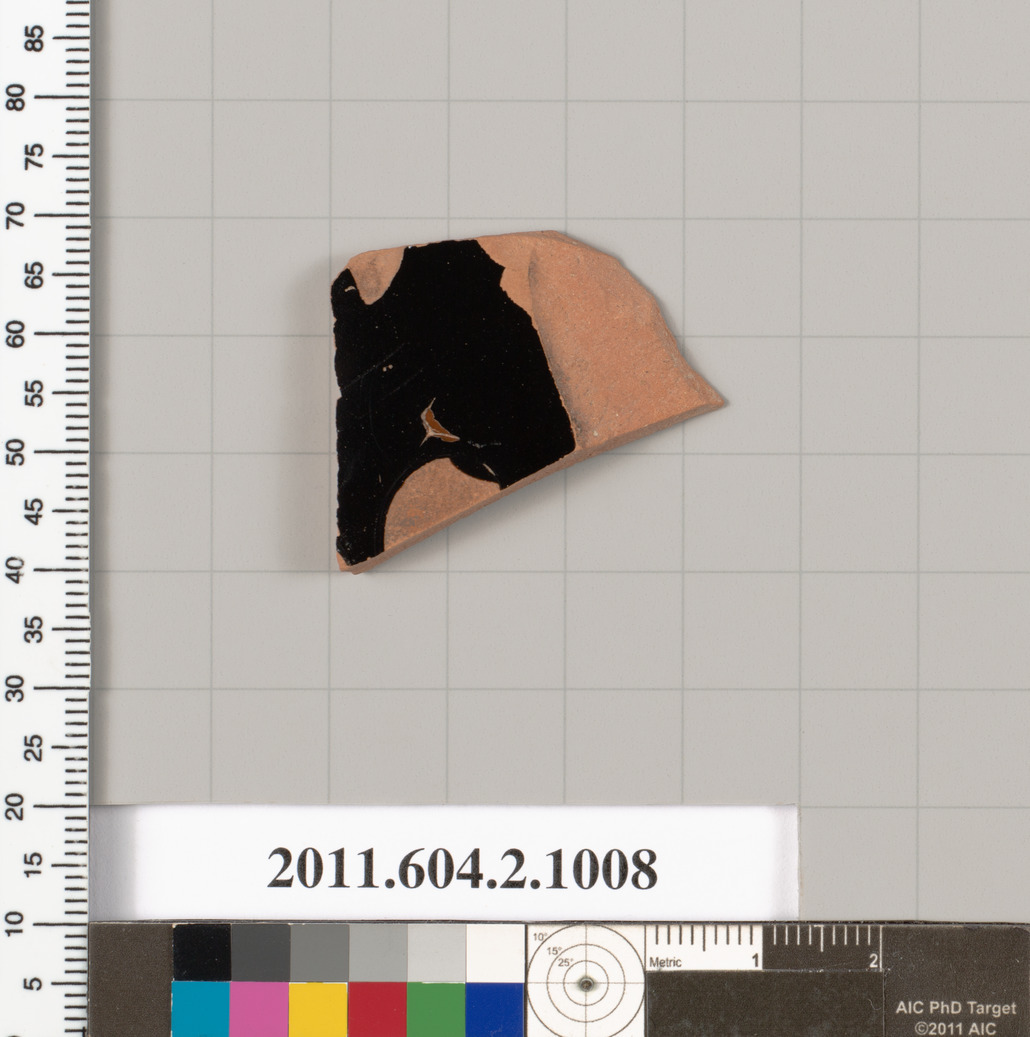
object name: oinochoe fragment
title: Terracotta fragment of an oinochoe (jug)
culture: greek, attic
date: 475-451 BCE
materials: terracotta